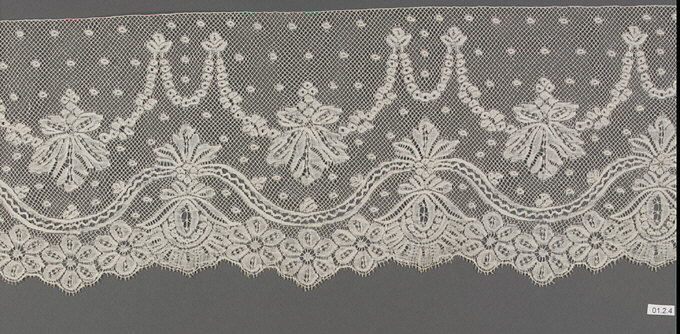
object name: piece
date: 1801-1900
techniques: lace